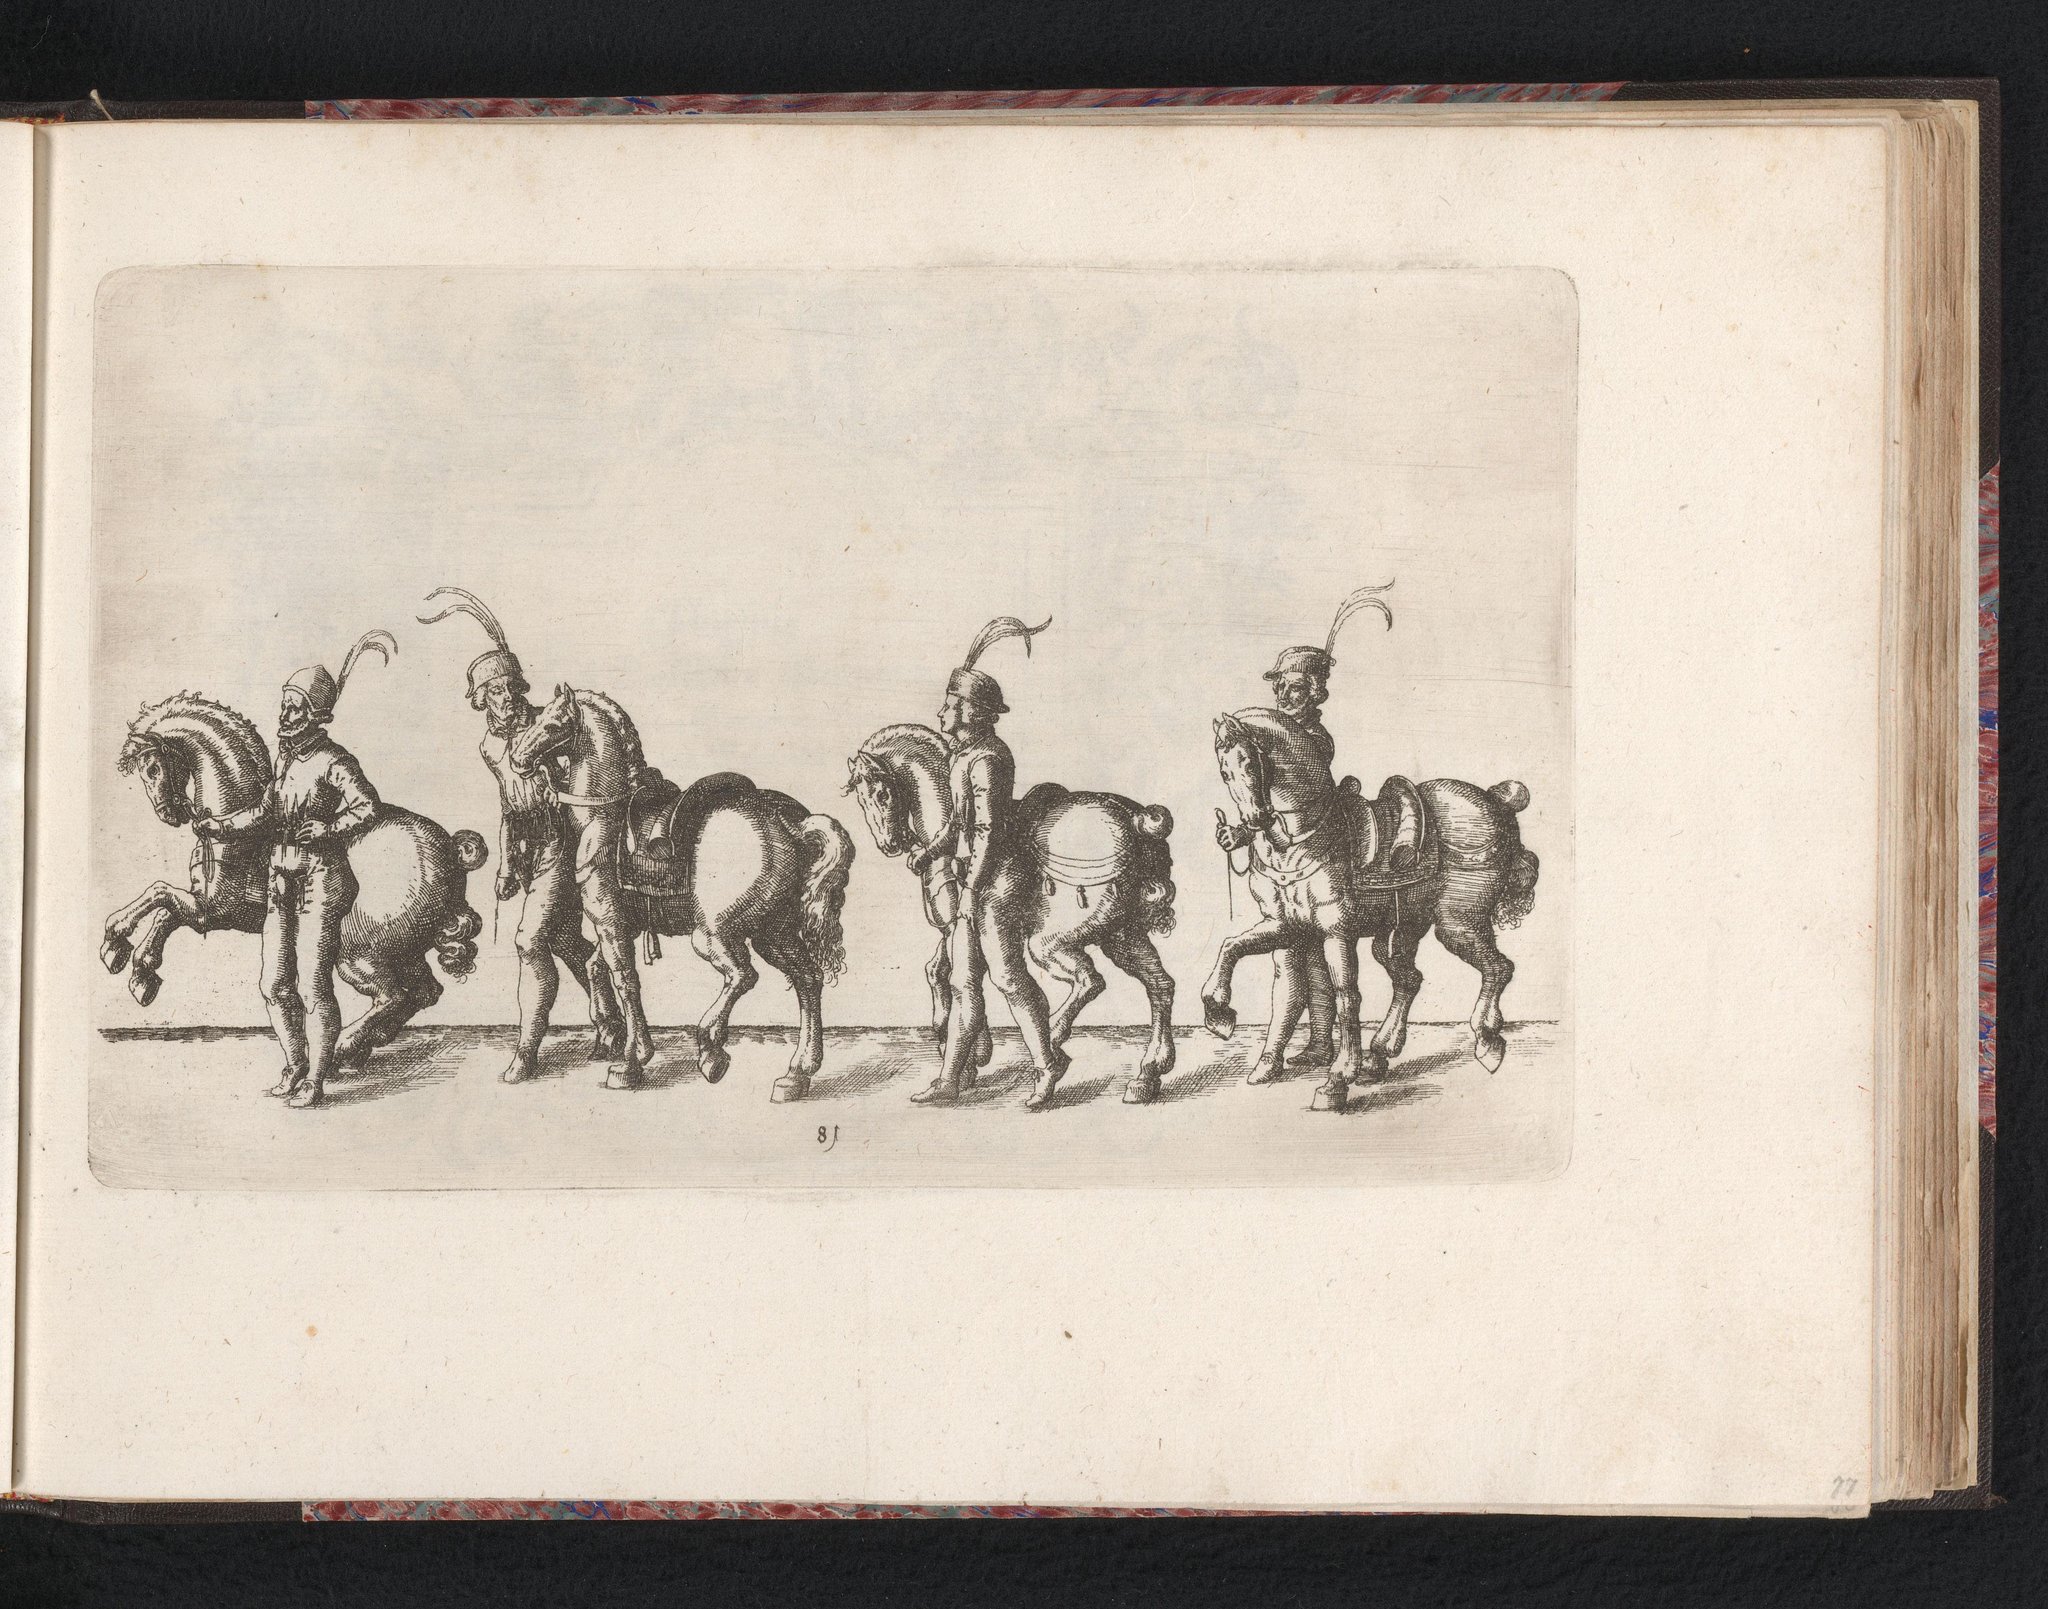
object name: print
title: Vier mannen met elk een paard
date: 1618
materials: paper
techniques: etching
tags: performance in the open air (pleasure fair), horses (circus performance)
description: Genummerd: 81. Deze prent maakt deel uit van een album.